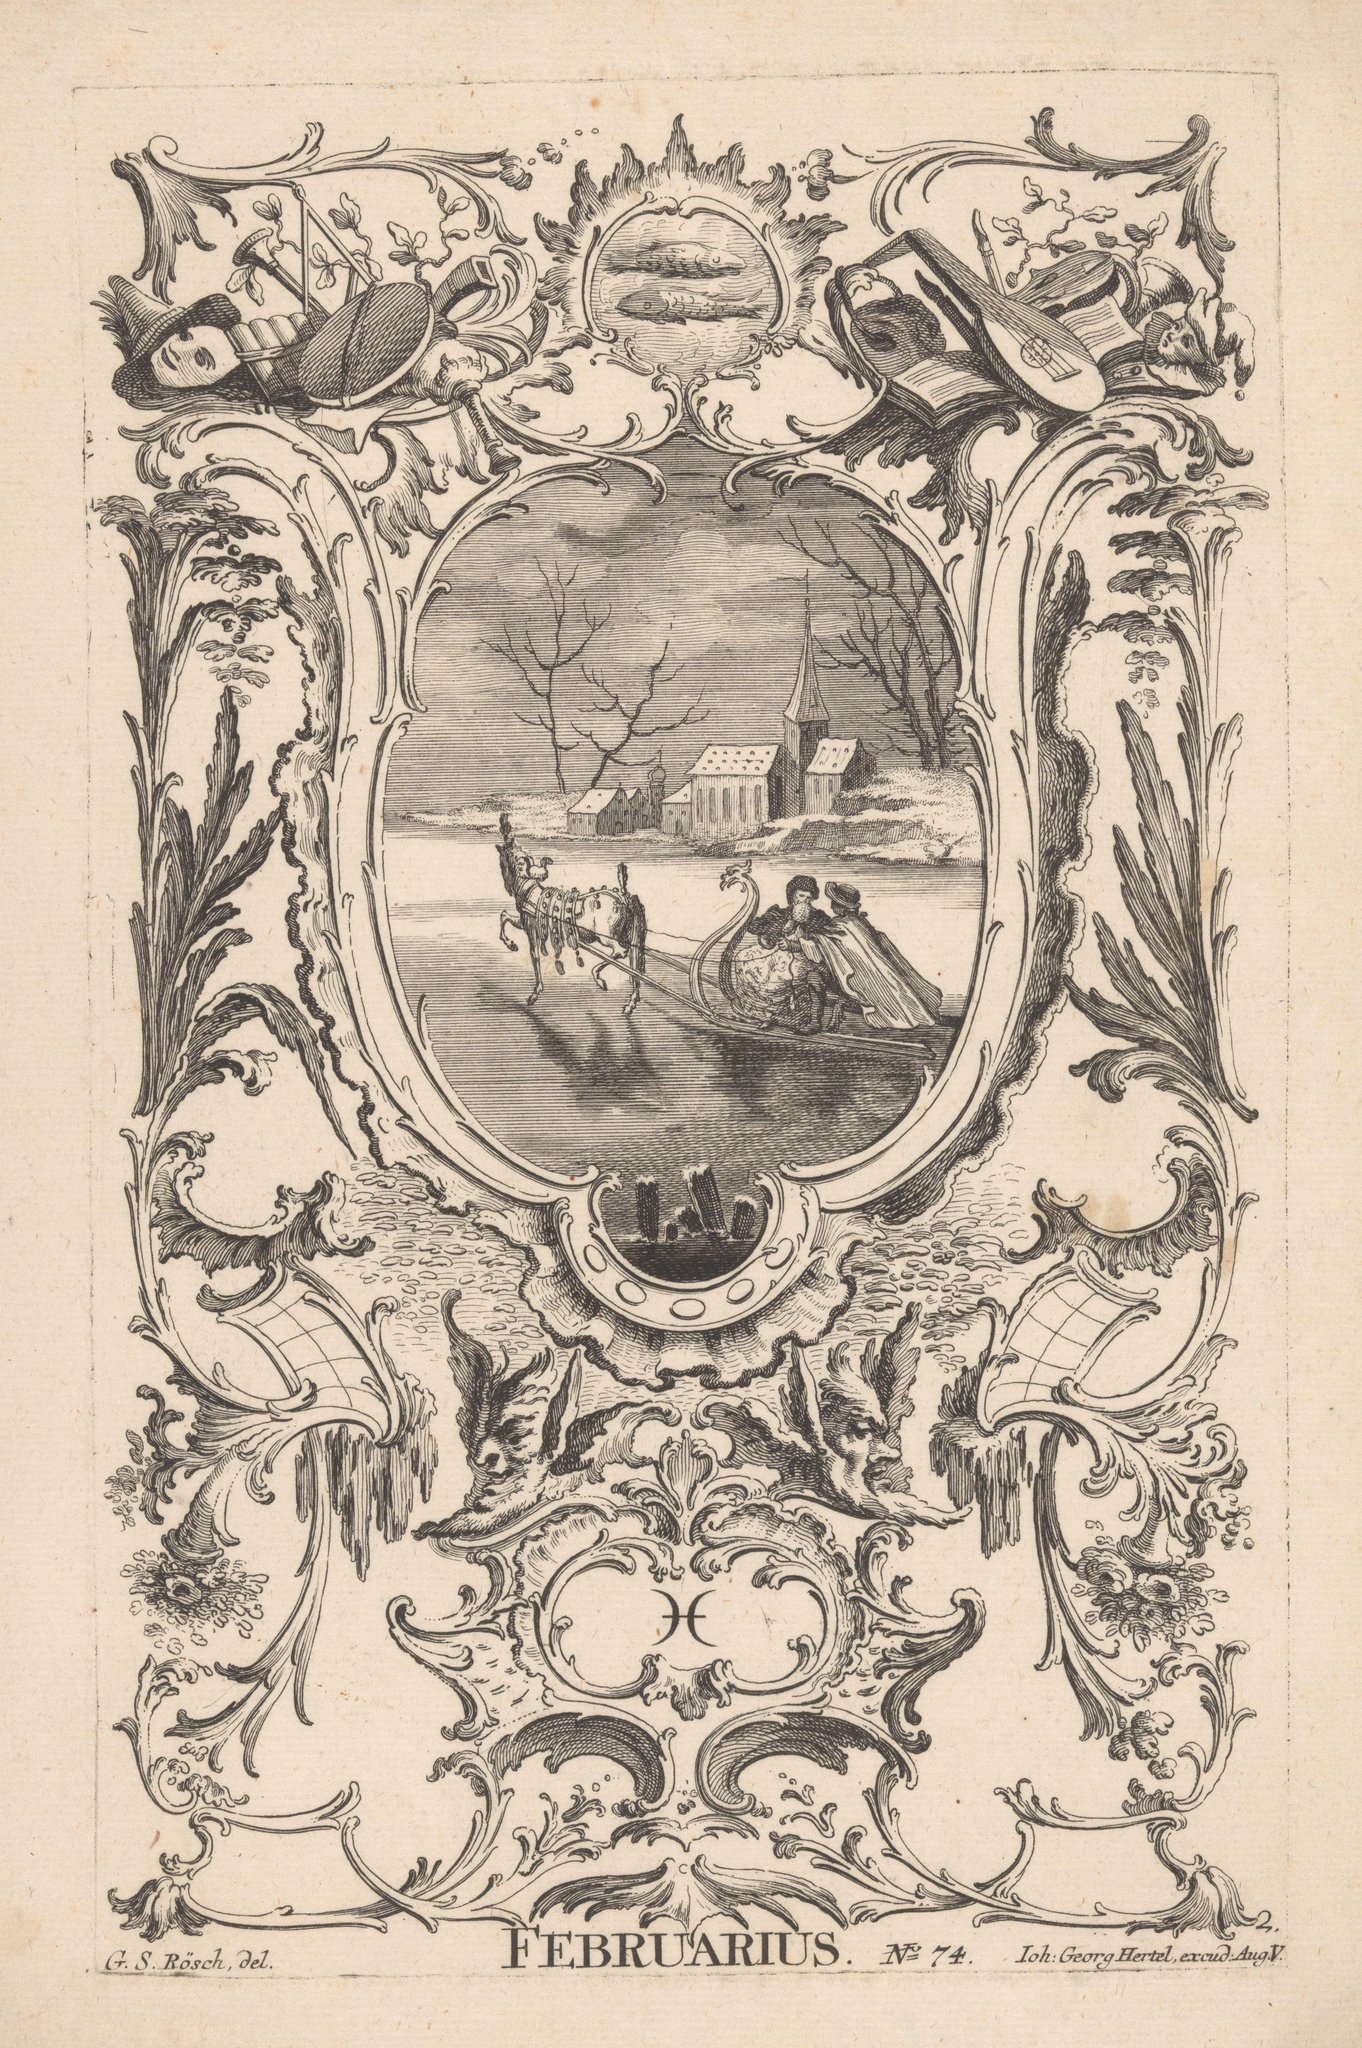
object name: print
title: Eerste zes maanden van het jaar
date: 1705-1766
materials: paper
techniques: etching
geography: augsburg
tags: horse-sleigh, february and its 'labours'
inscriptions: collector's mark: Lugt 2228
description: In een rocaille cartouche figuren op een arrenslee. Rondom de voorstelling rocaille ornamenten, muziekinstrumenten, vissen, het bijbehorende teken van de dierenriem en fantasiekoppen. Uitgeversnummer 74.